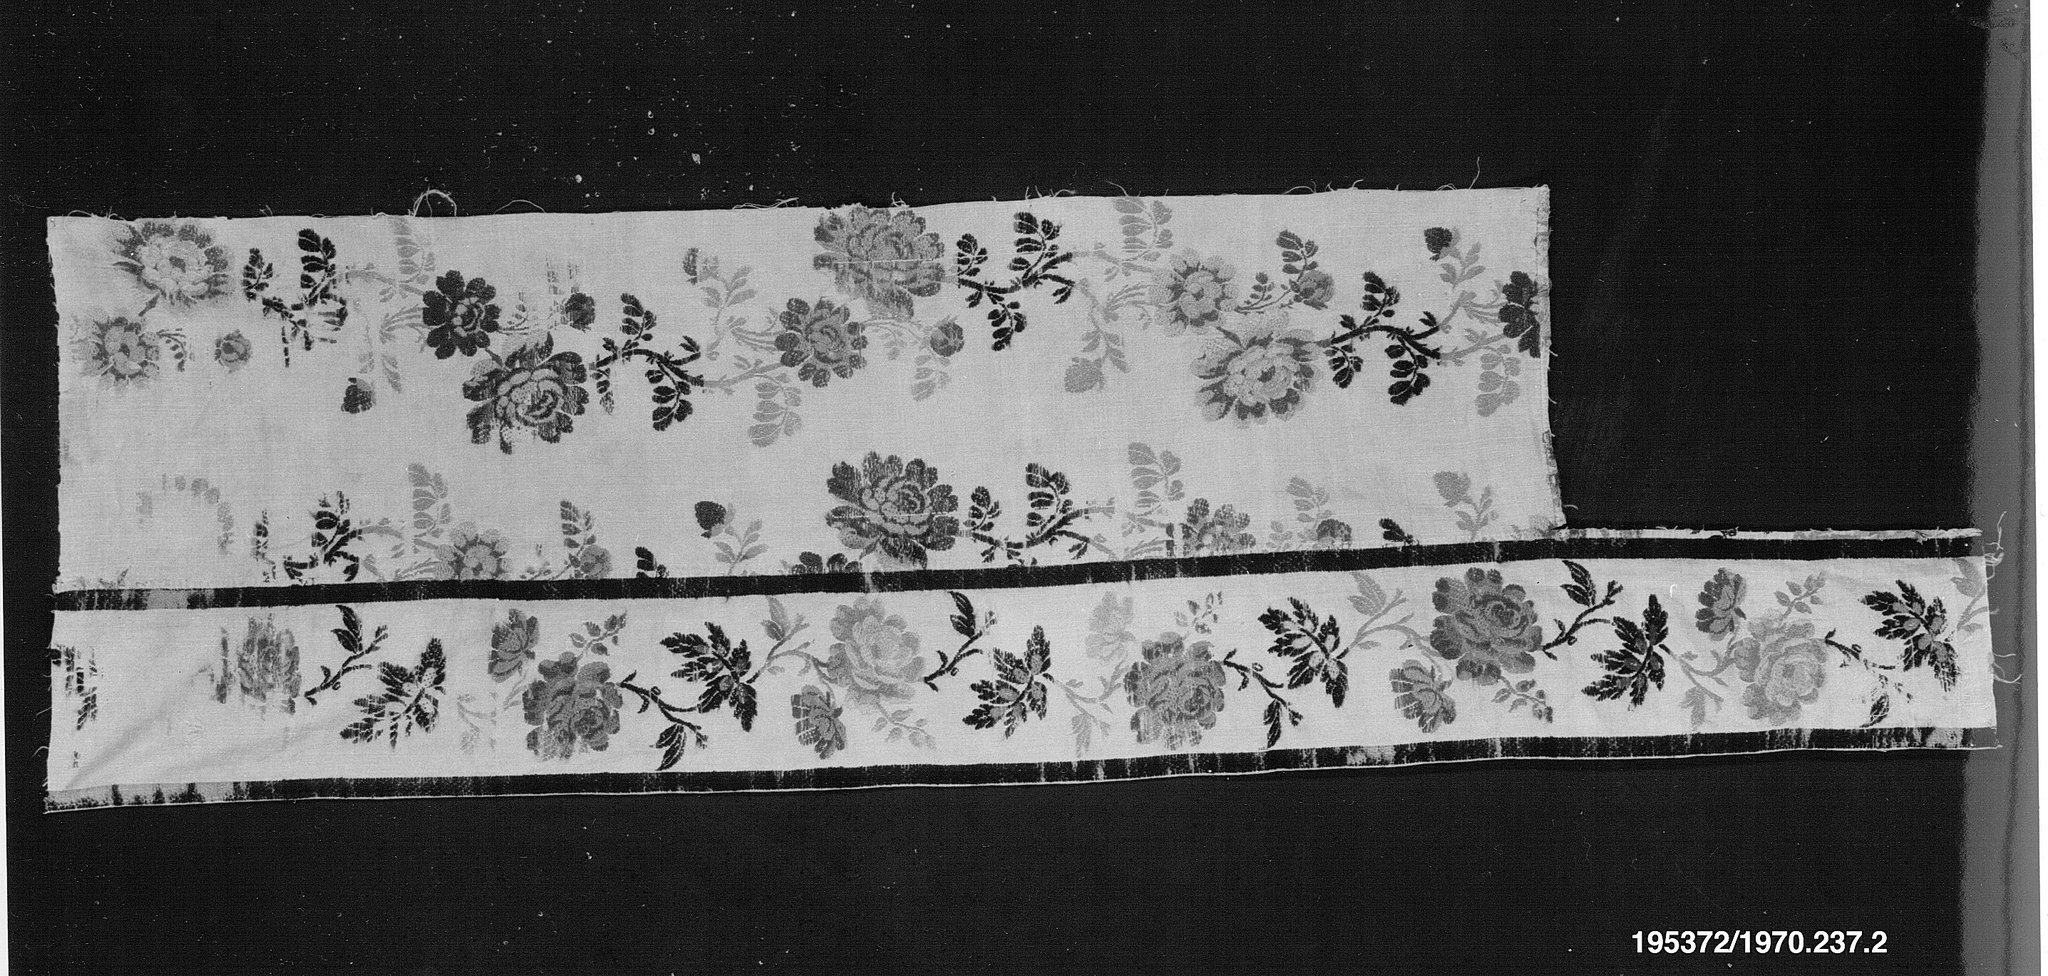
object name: panel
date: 1701-1800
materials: cotton, linen, wool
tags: flowers,leaves